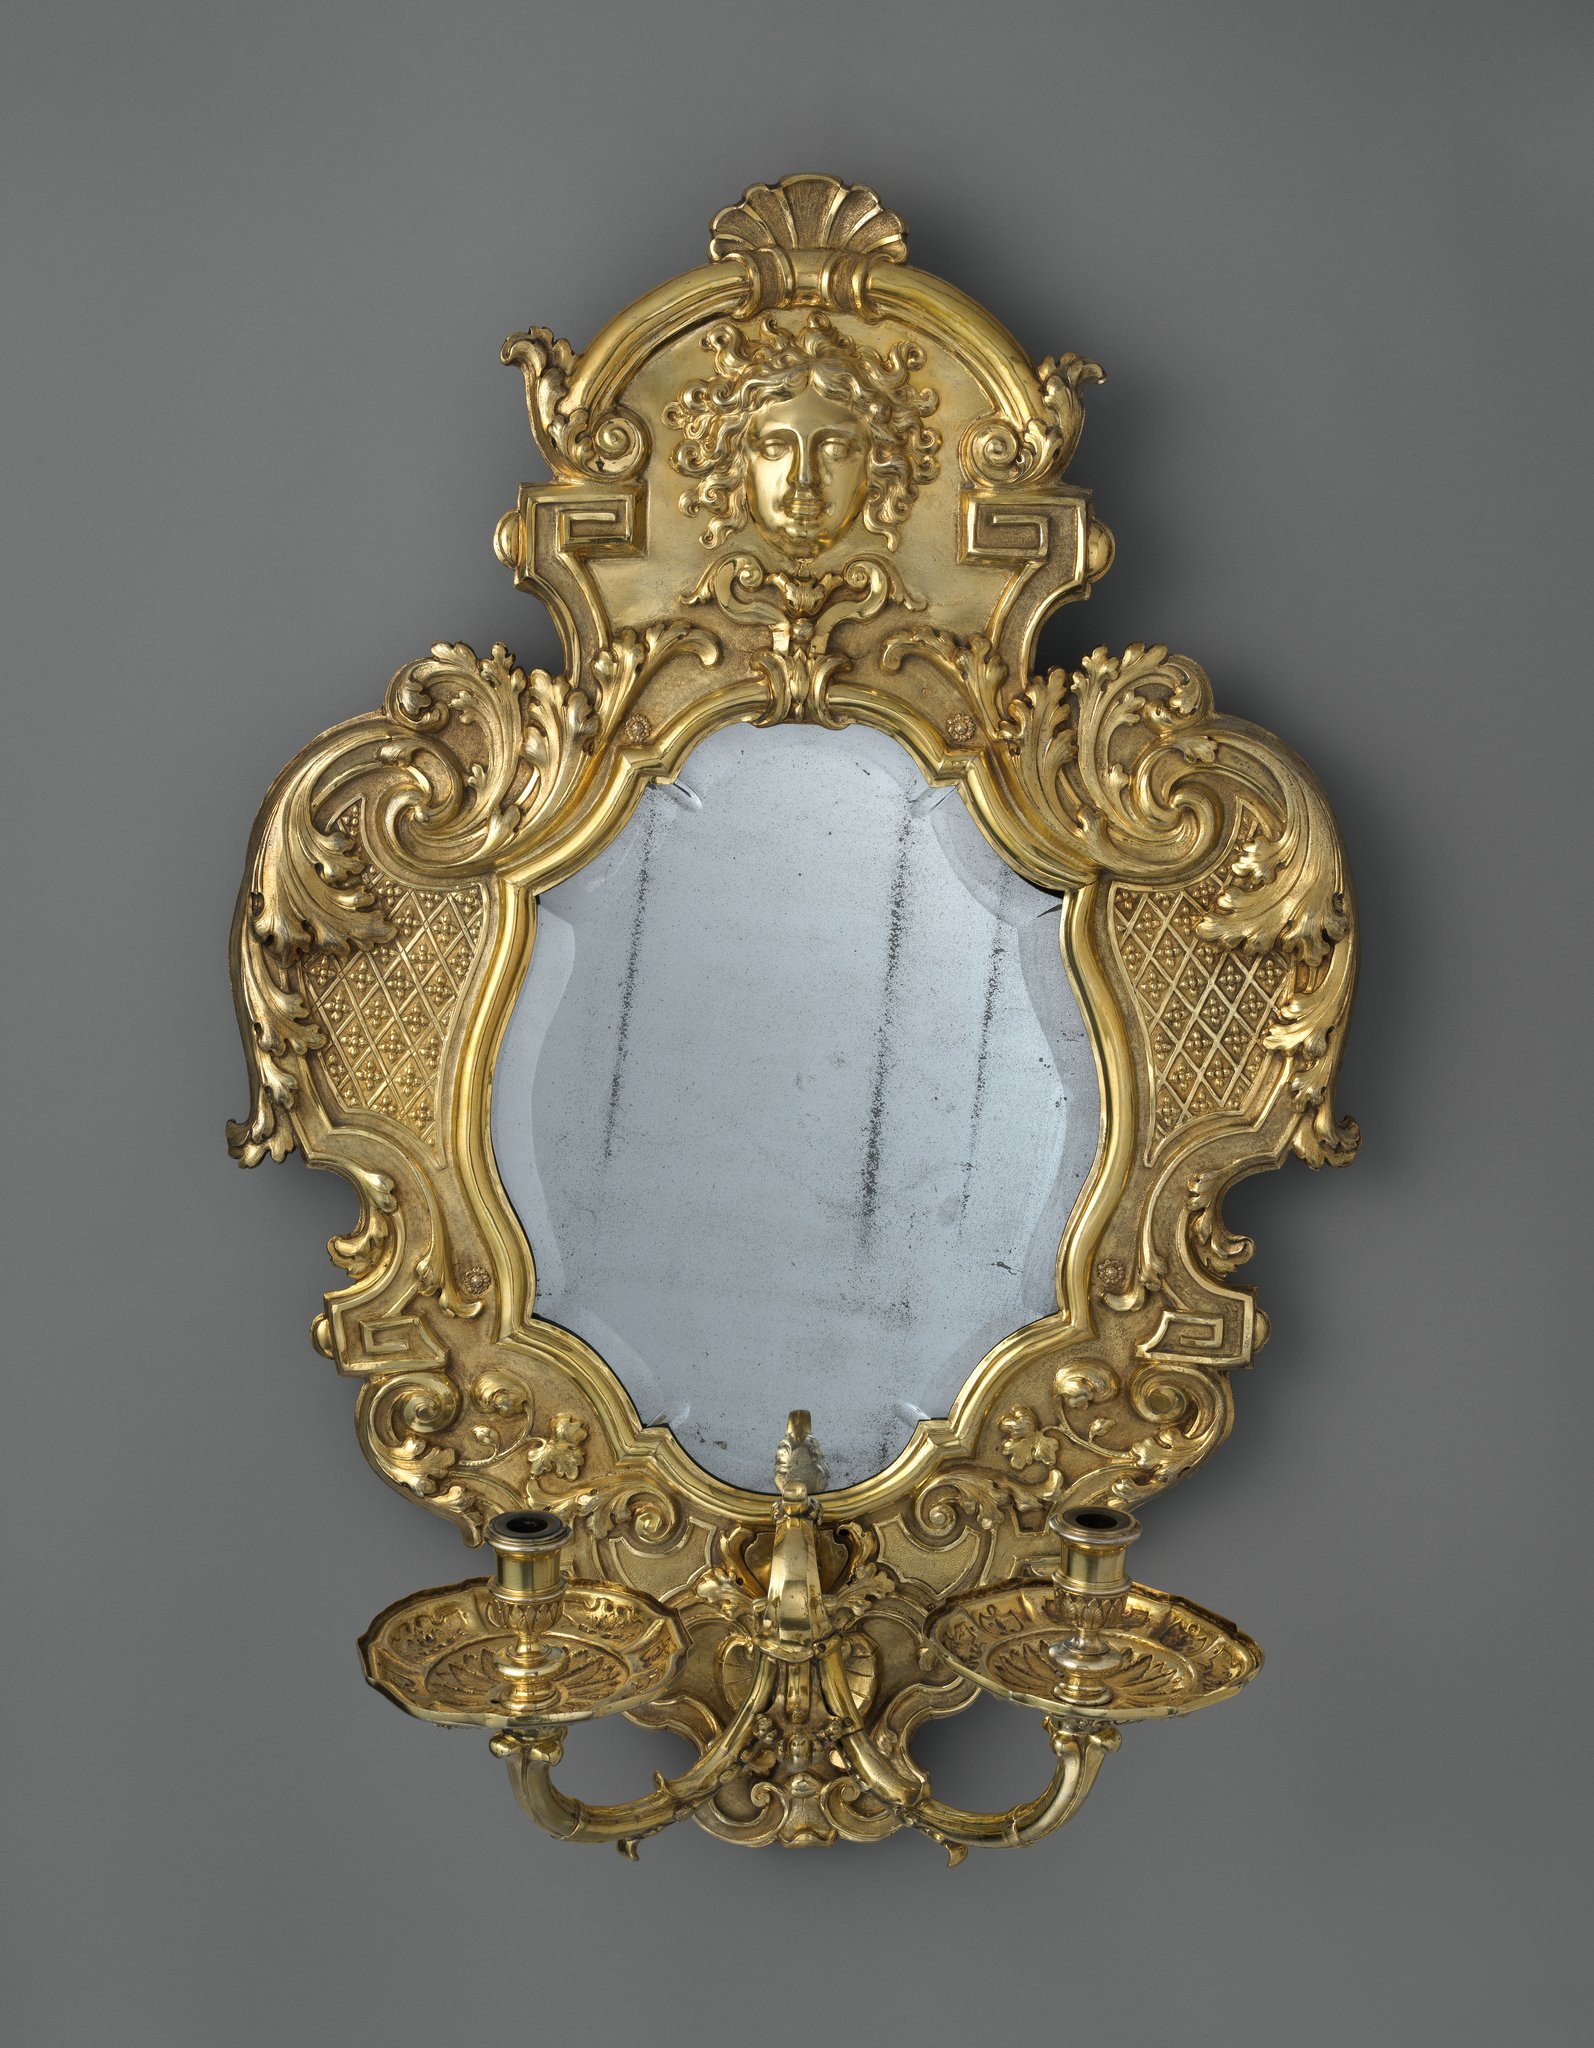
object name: sconce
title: Monumental mirror sconce (one of a pair)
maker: peter rahm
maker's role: maker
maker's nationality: german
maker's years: 1661-1737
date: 1717-1718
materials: glass, silver, wood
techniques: embossing, engraving, gilding